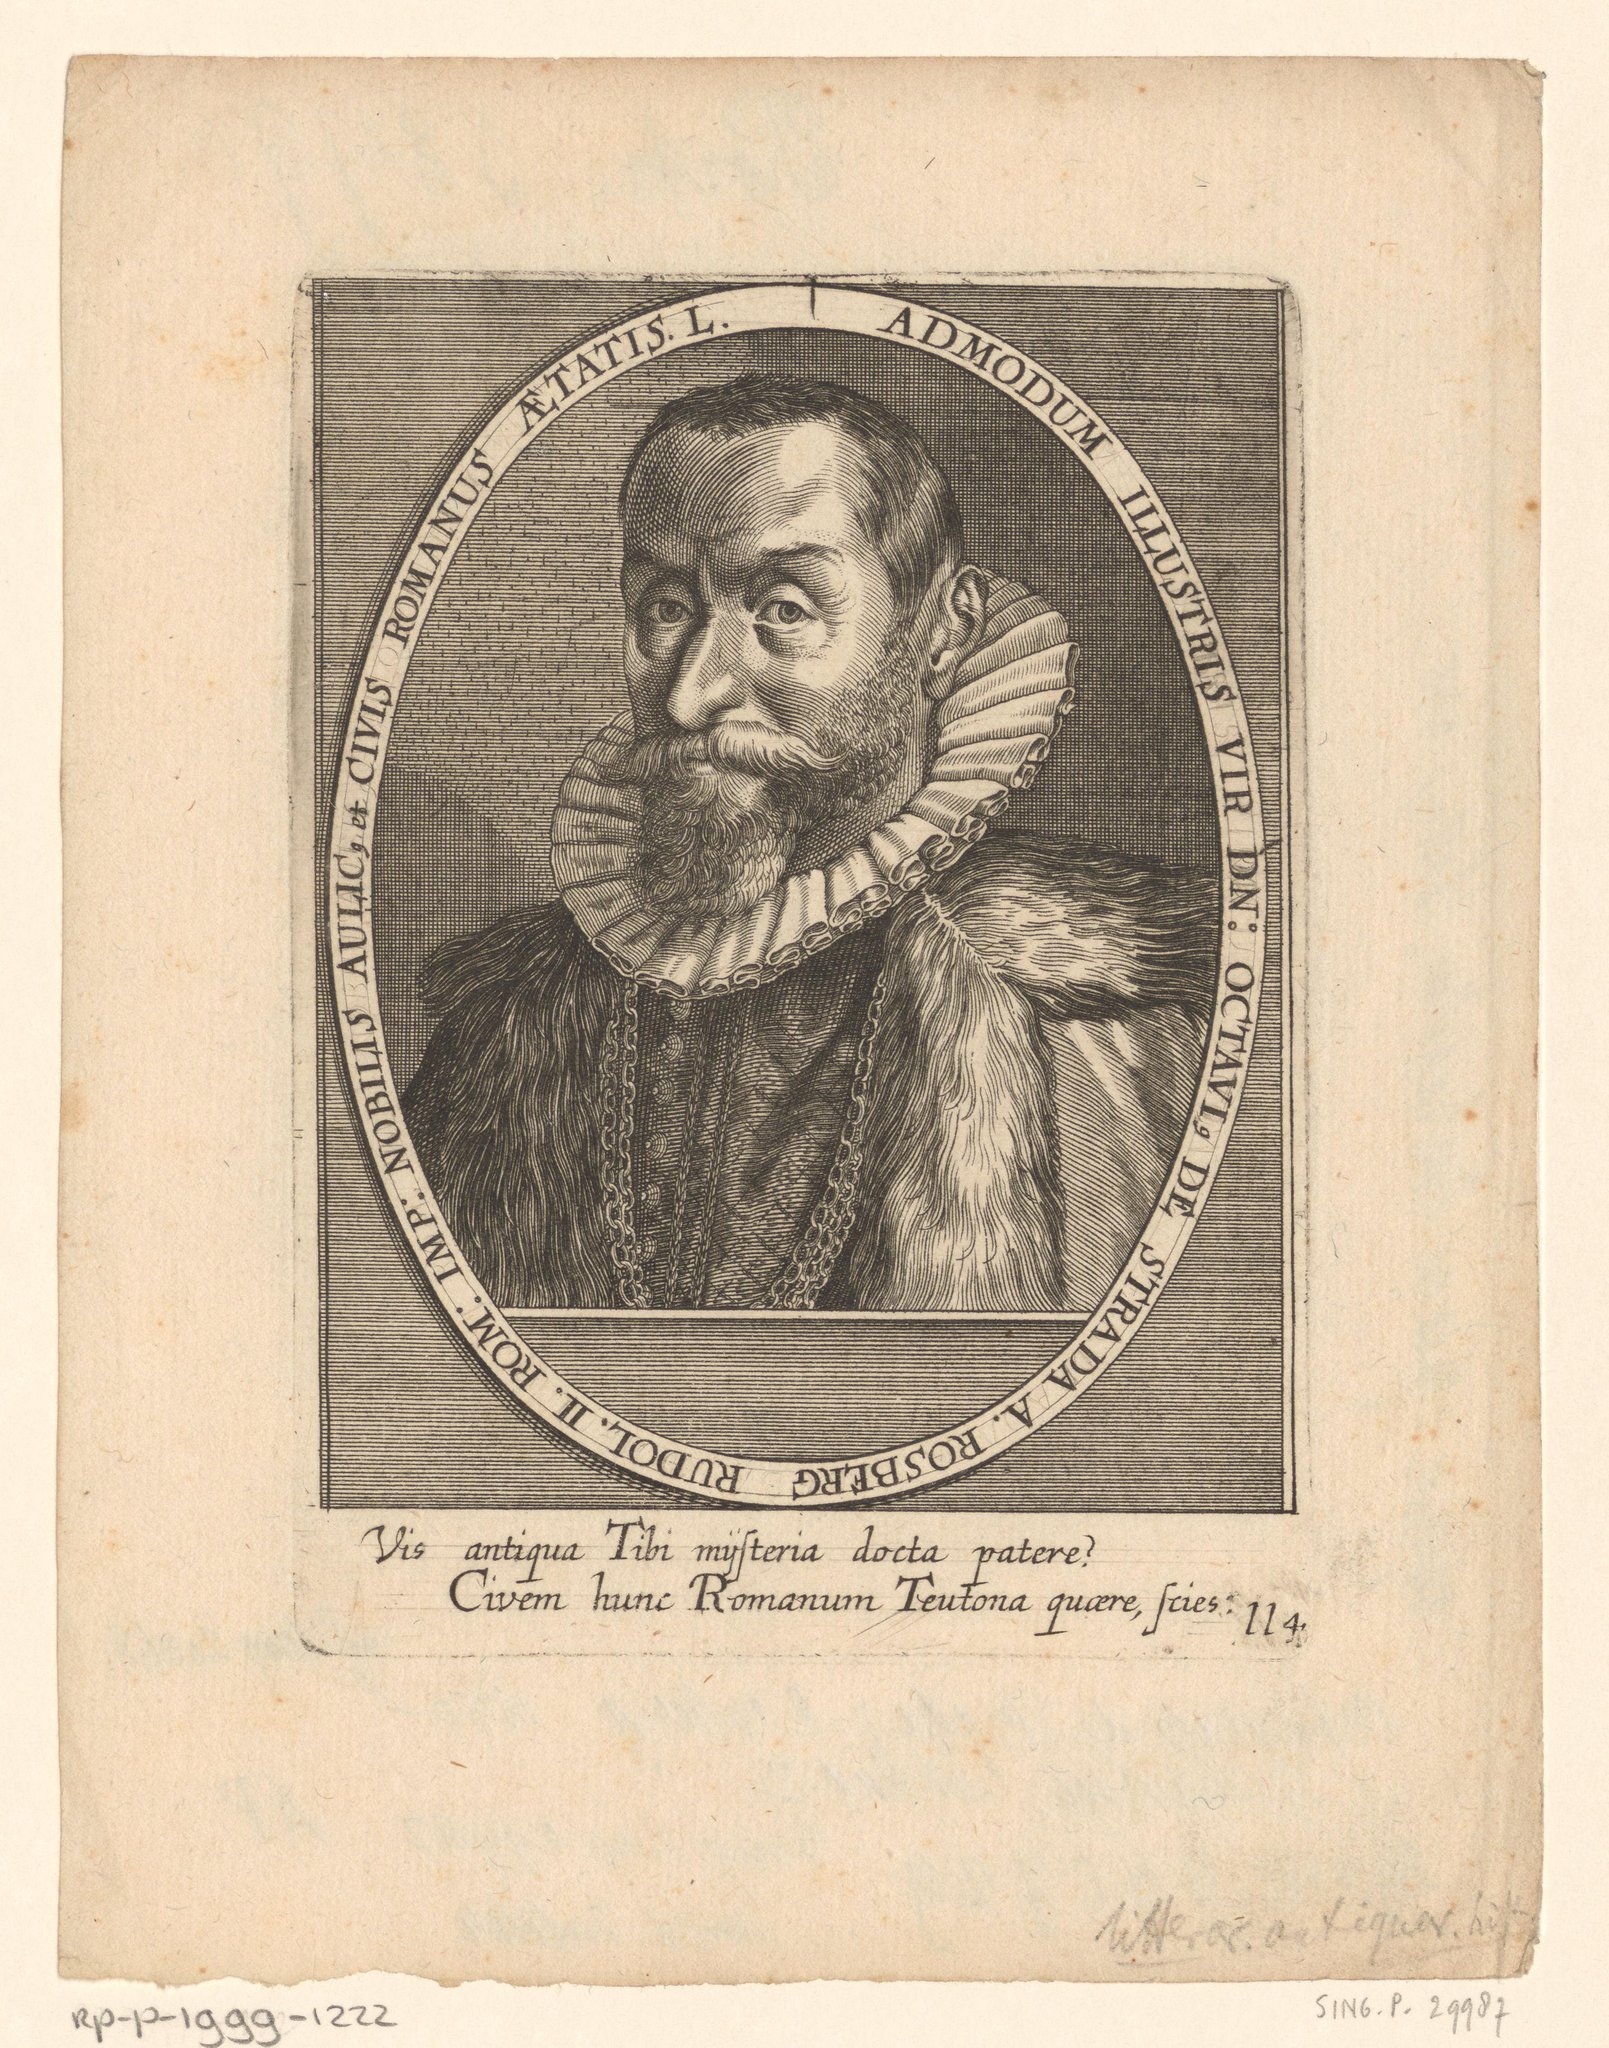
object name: print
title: Portretten van geleerden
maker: clemens ammon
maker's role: print maker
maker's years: 1627-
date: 1650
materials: paper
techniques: engraving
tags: draughtsman, goldsmith, ottavio strada, history and archaeology (+ portrait of scholar, scientist), historical persons, portrait, self-portrait of artist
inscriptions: collector's mark: Lugt 2760, collector's mark: Lugt 2228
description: Prent waarschijnlijk uit: Boissard, Jean Jacques. Bibliotheca chalcographica (...) VII pars. Frankfurt am Main: Johannes Ammon, 1650. Prent ook gebruikt in de editie van 1669.